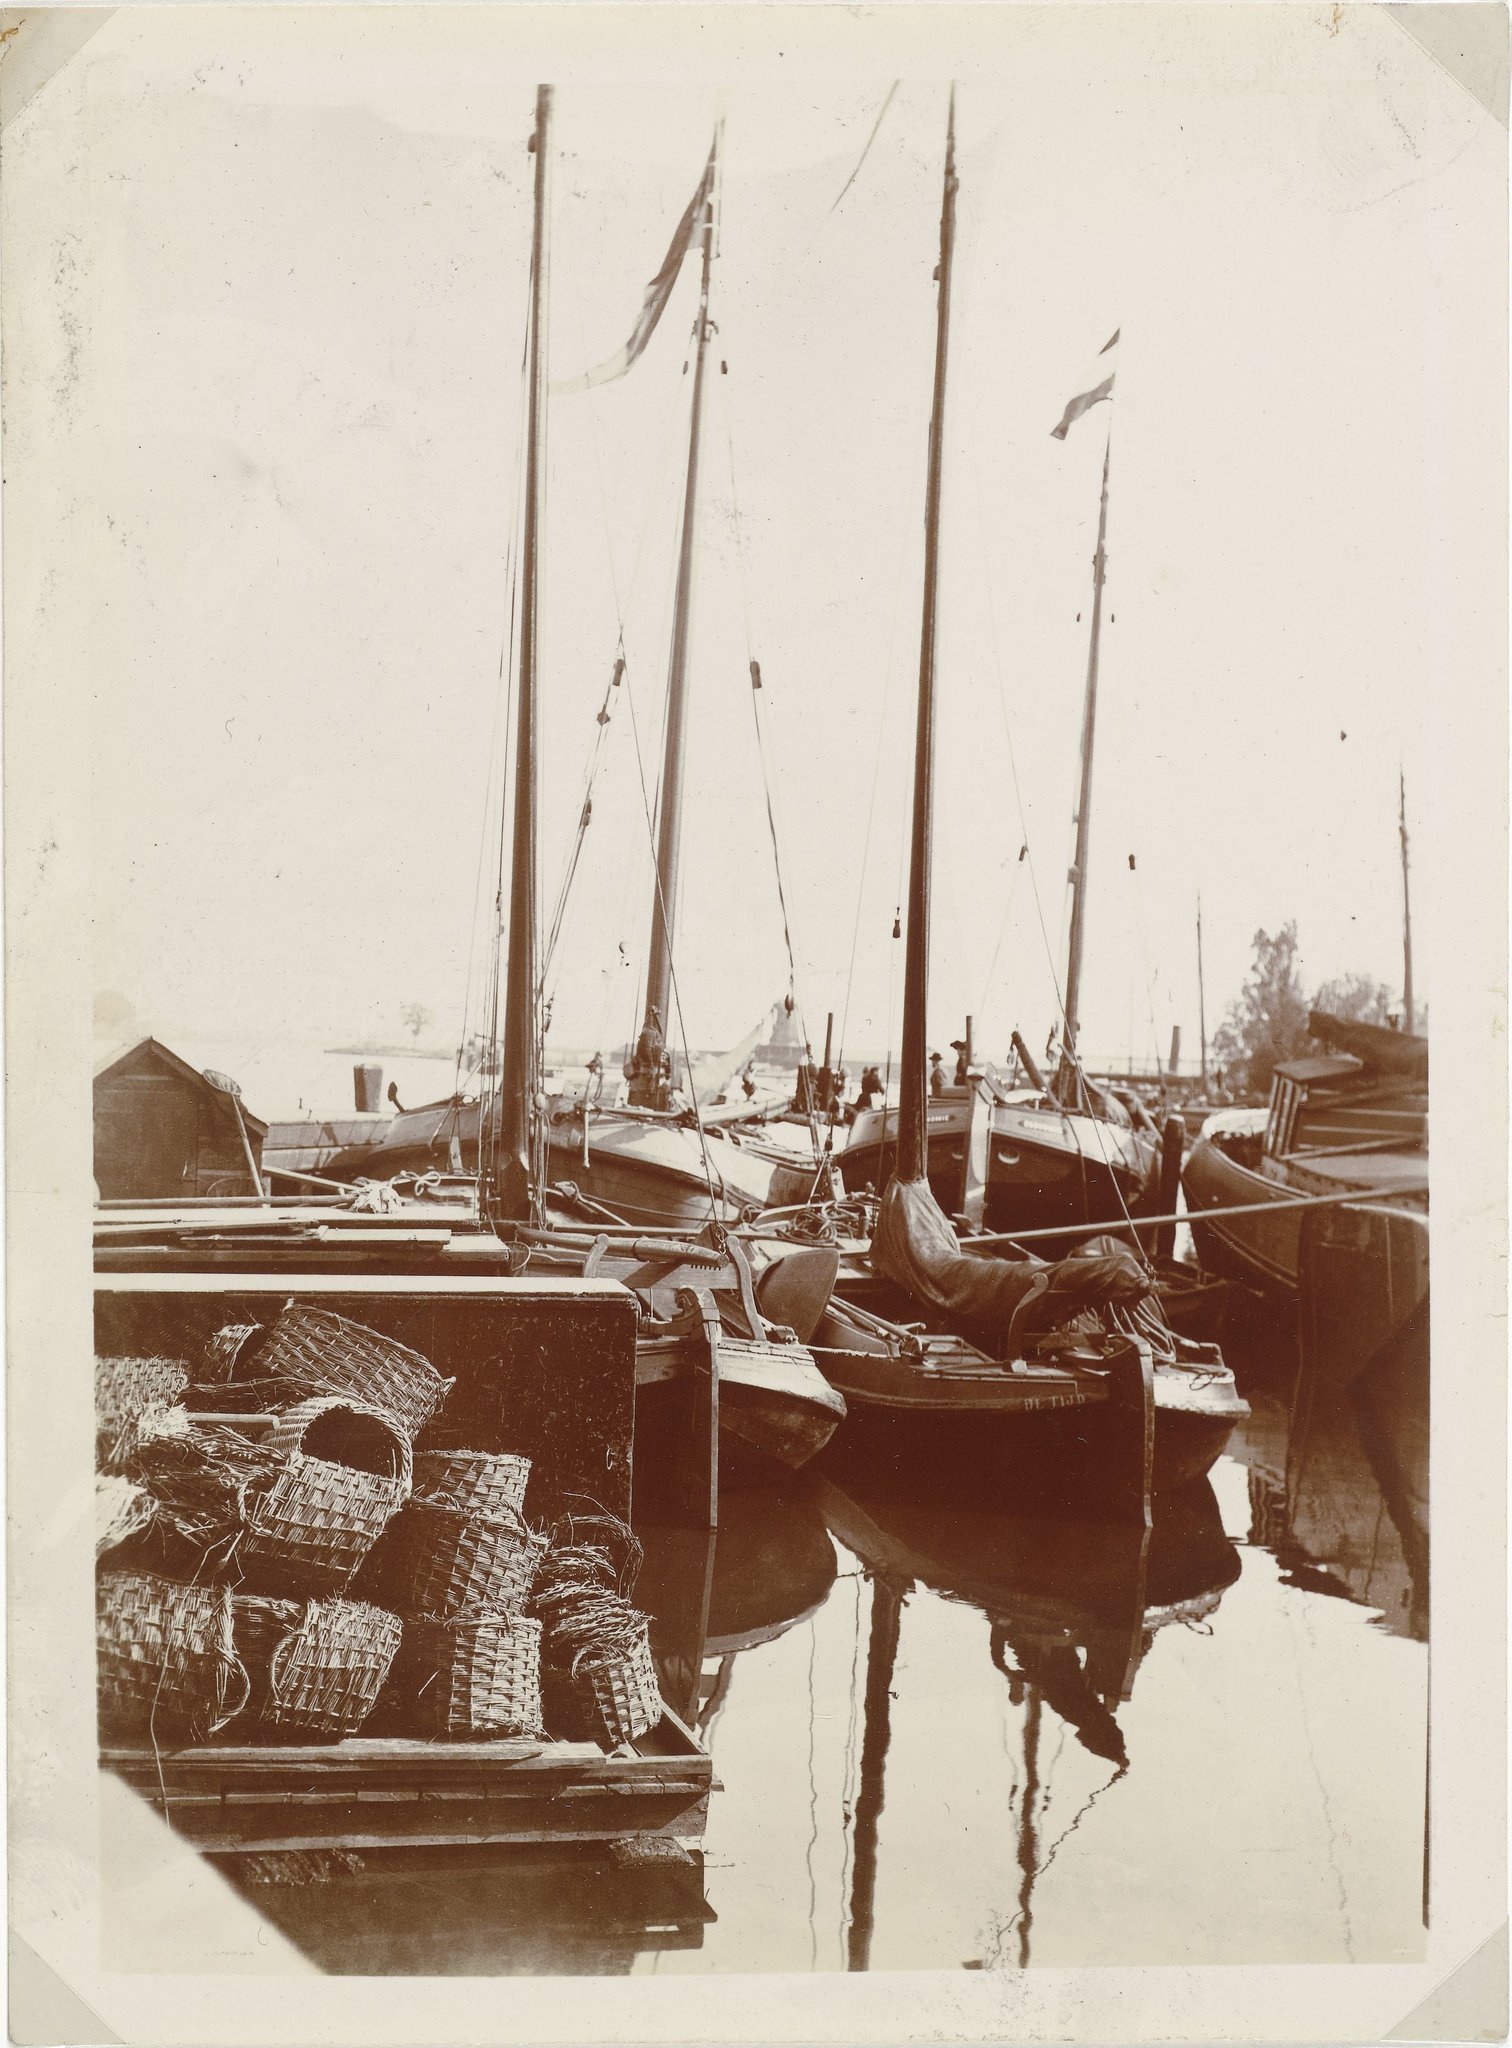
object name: photograph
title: Vlonder met rieten manden en vissersschepen in de haven van Zaandam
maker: james higson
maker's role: politician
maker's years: 1862-1933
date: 1904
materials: paper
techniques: gelatin silver print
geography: zaandam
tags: harbour